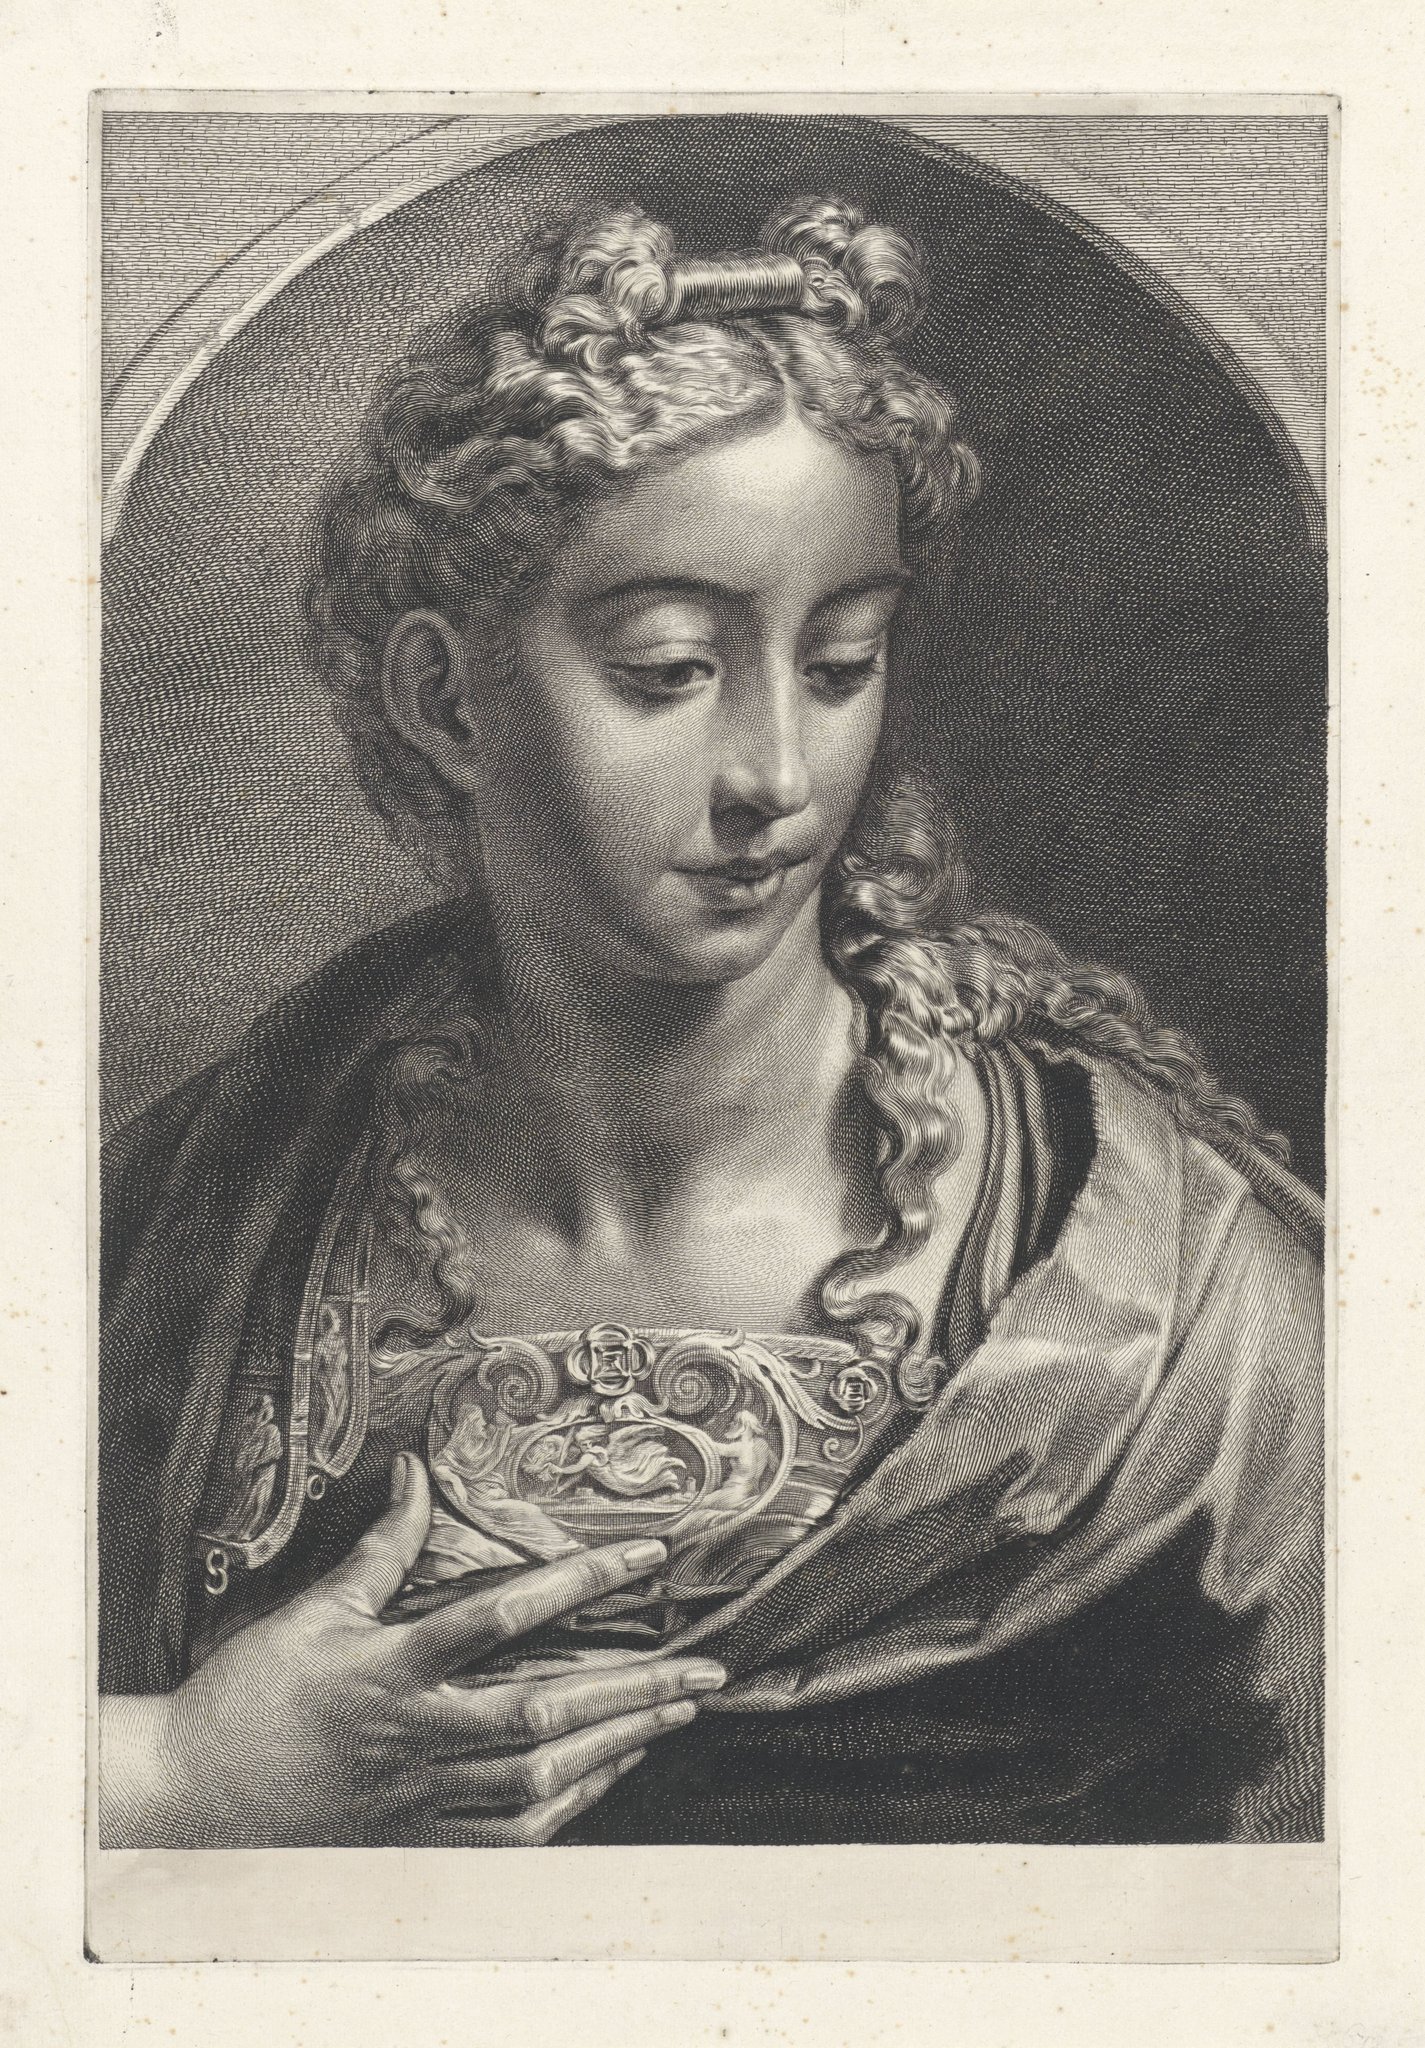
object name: print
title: Minerva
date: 1638-1658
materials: paper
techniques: engraving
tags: (story of) minerva (pallas, athena)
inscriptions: collector's mark: Lugt 240